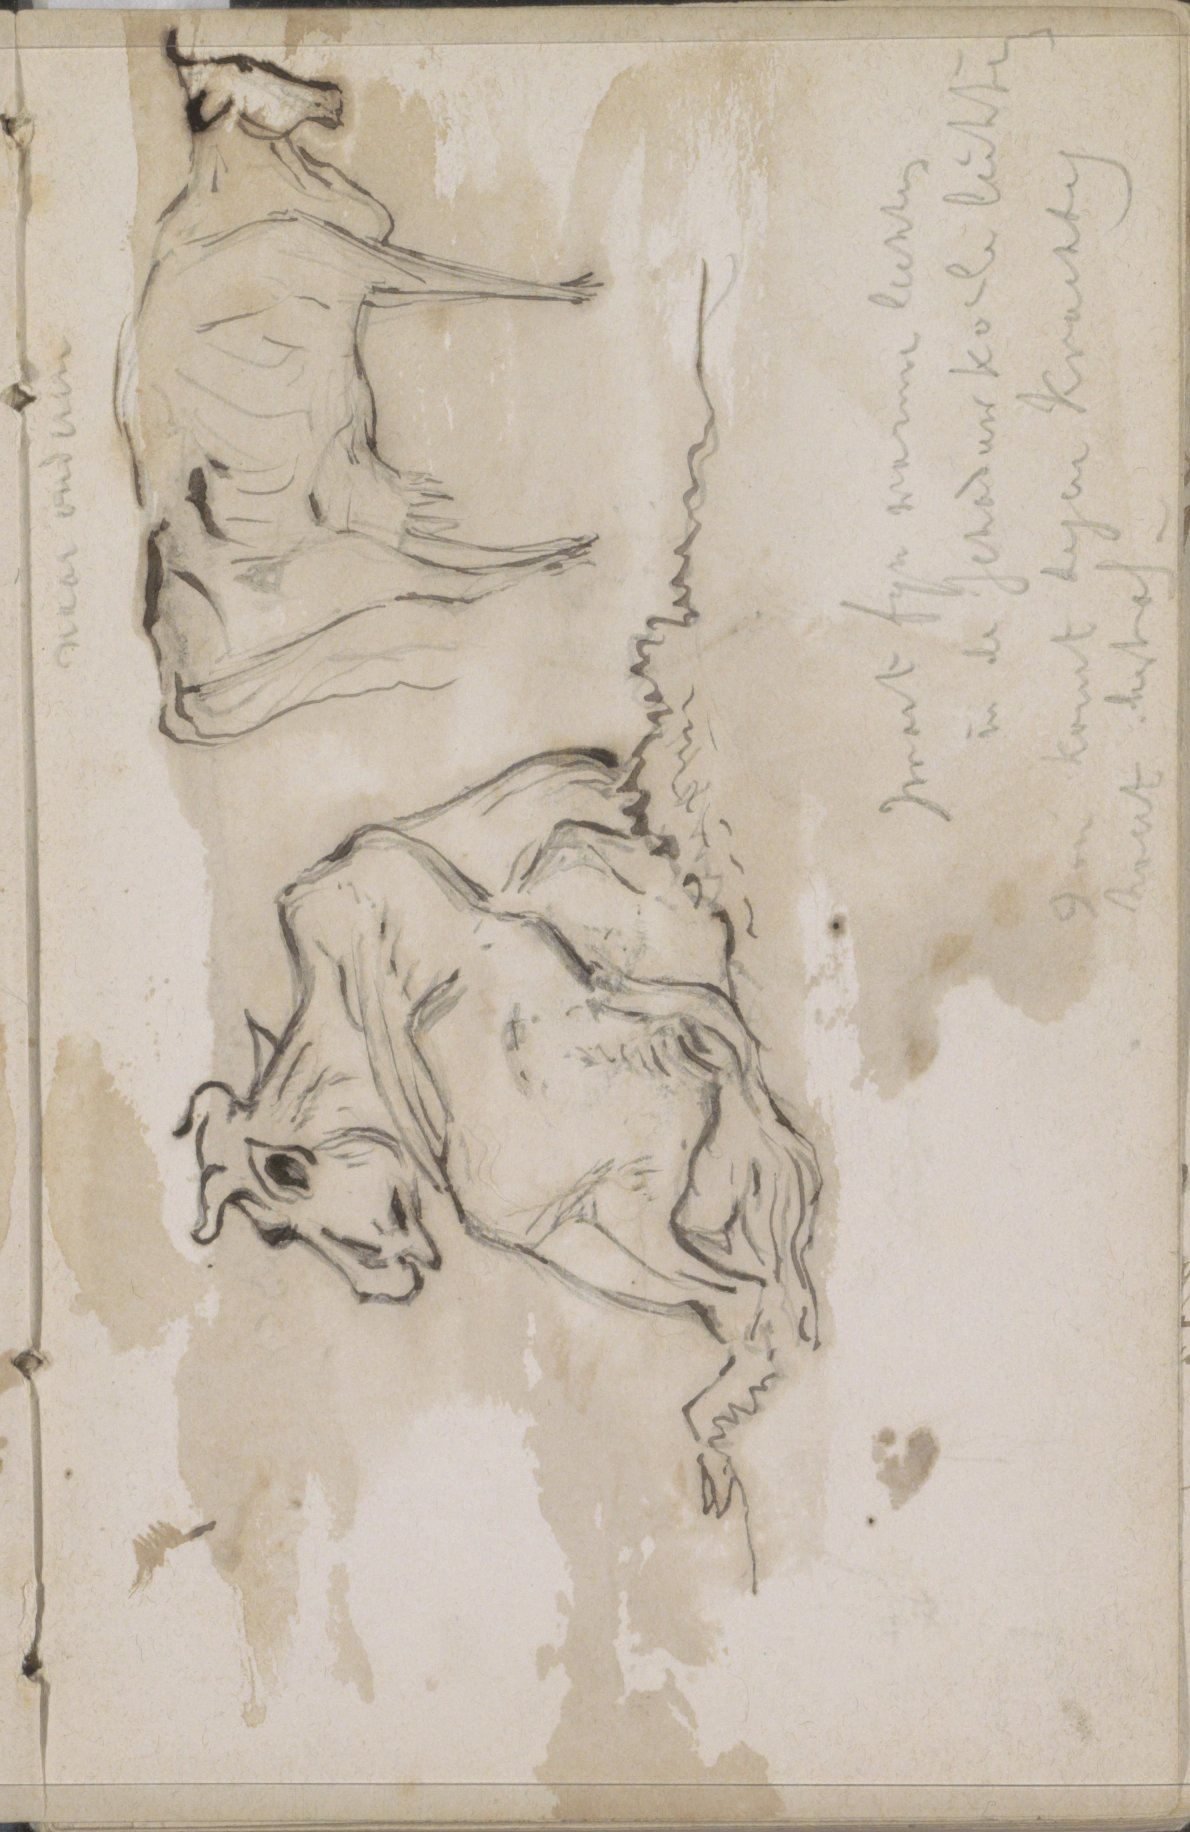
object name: sketchbook leaf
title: Liggende en staande koe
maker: johannes tavenraat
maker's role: draughtsman, painter, print maker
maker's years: 1809-1881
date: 1862-1864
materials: ink, paper, pencil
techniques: brush, pen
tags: cow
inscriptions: kleurnotitie, handgeschreven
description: Blad 4 recto uit een schetsboek met 65 bladen.